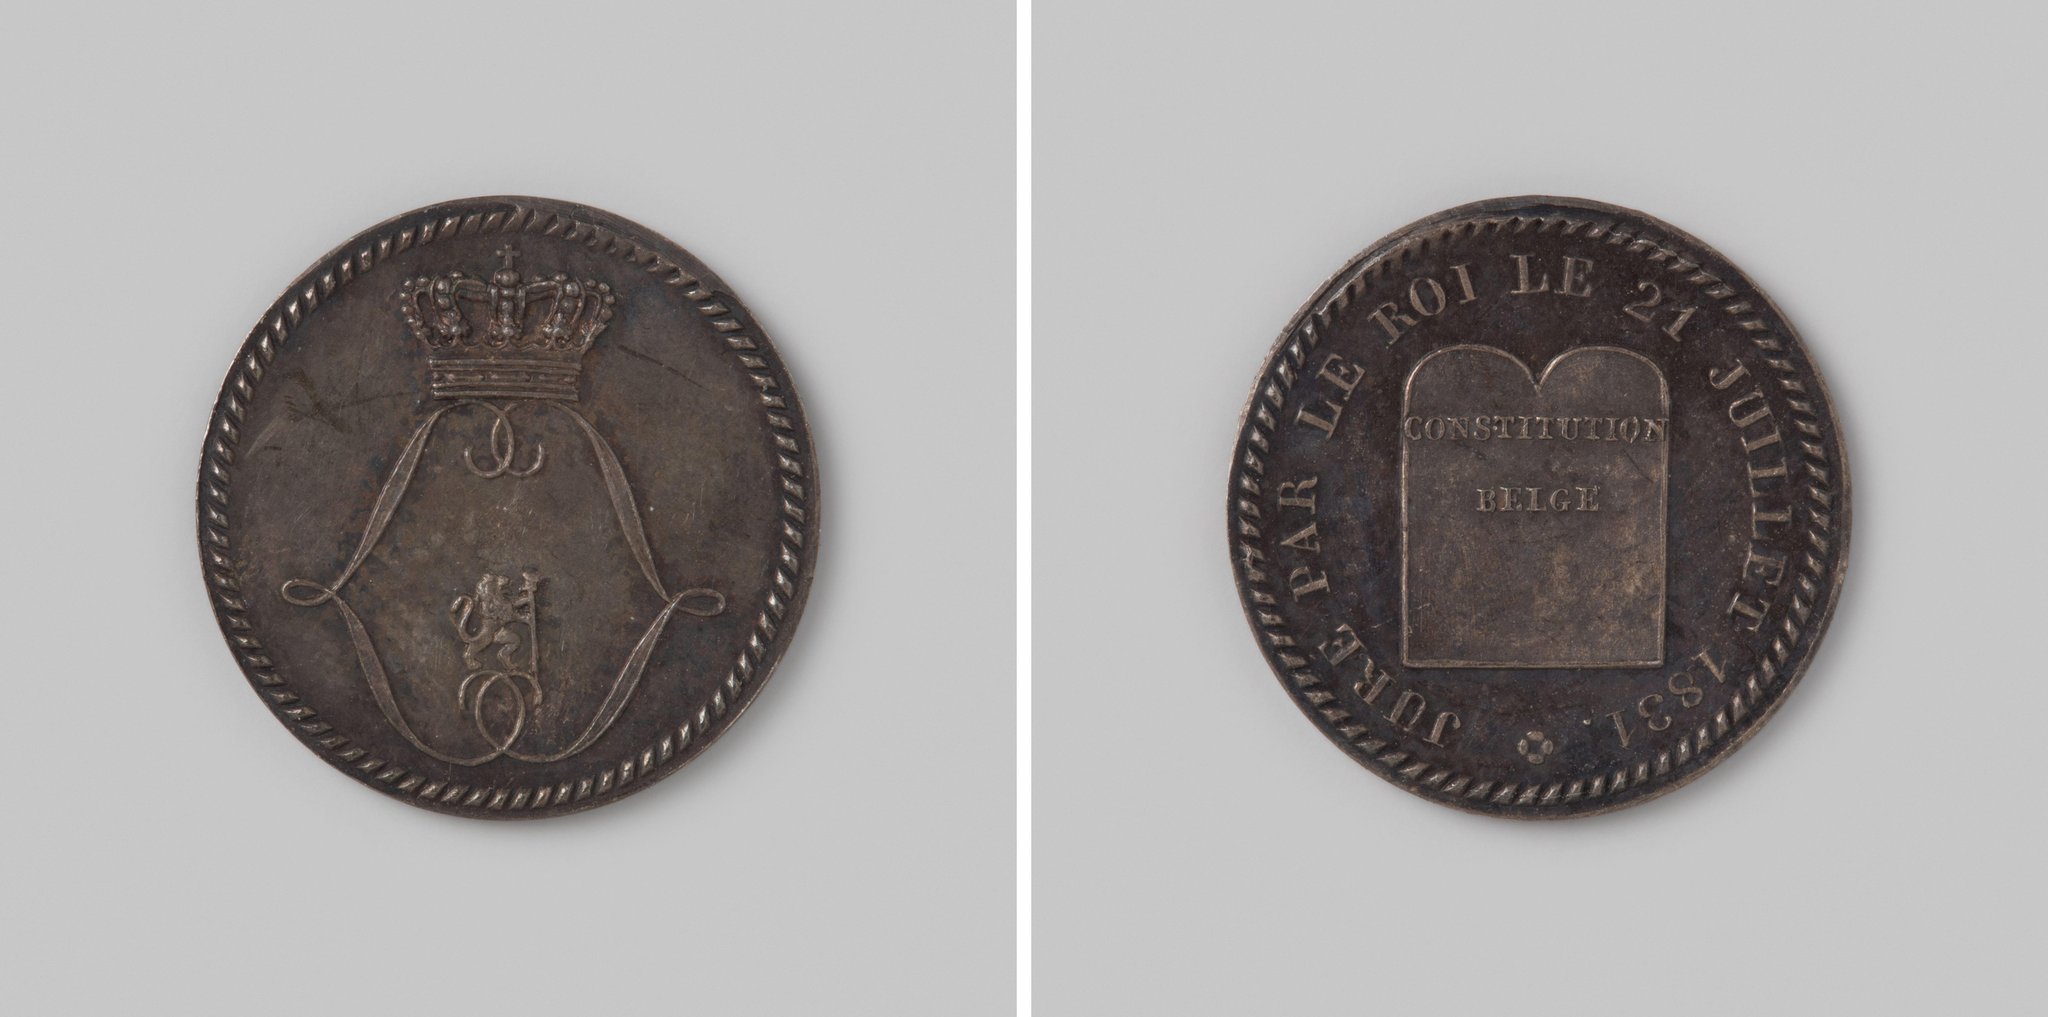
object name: strooipenning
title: Eed van Leopold van Saksen-Coburg op de constitutie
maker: adrien hippolyte veyrat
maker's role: medailleur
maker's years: 1803-1883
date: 1831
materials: silver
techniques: striking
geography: brussels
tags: laeken, leopold i (koning der belgen), brussels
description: Zilveren penning. Voorzijde: leeuwtje met vrijheidsstaf in monogram van twee letters L onder kroonbinnen kabelrand. Keerzijde: bord met opschrift binnen omschrift en kabelrand